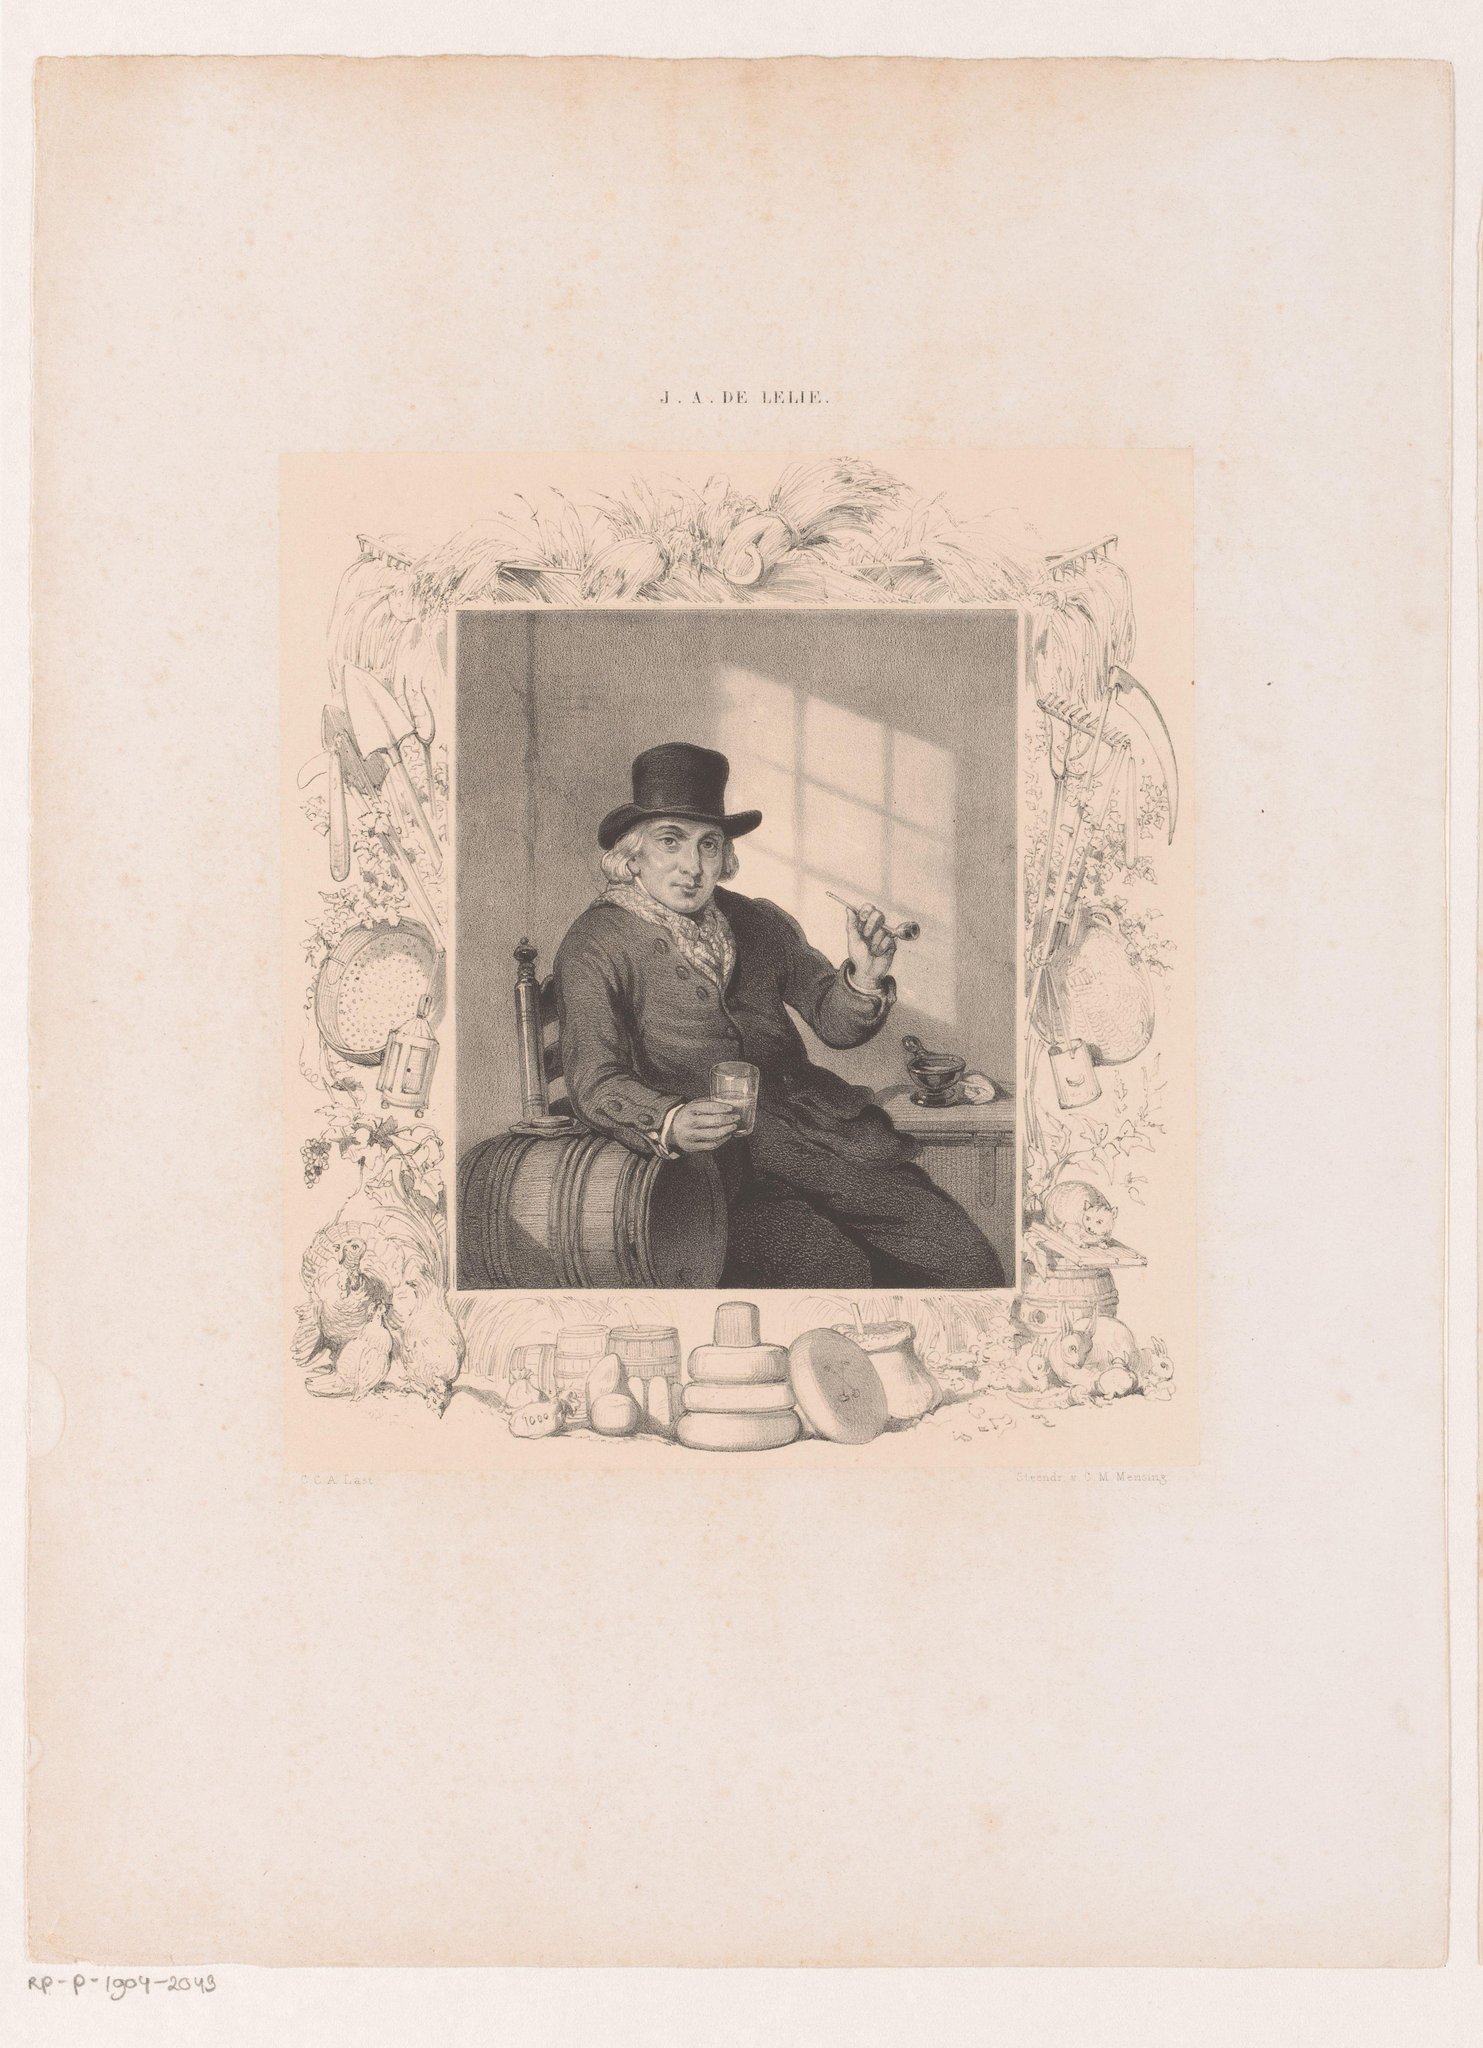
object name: print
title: Man met glas en pijp naast vat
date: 1818-1876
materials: paper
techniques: lithograph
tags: pipe ~ tobacco, glass, rummer, historical persons (+ three-quarter length portrait)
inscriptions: collector's mark: Lugt 2228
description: De man draagt een hoge hoed. In de rand zuivelproducten, dieren, werktuigen en graan.